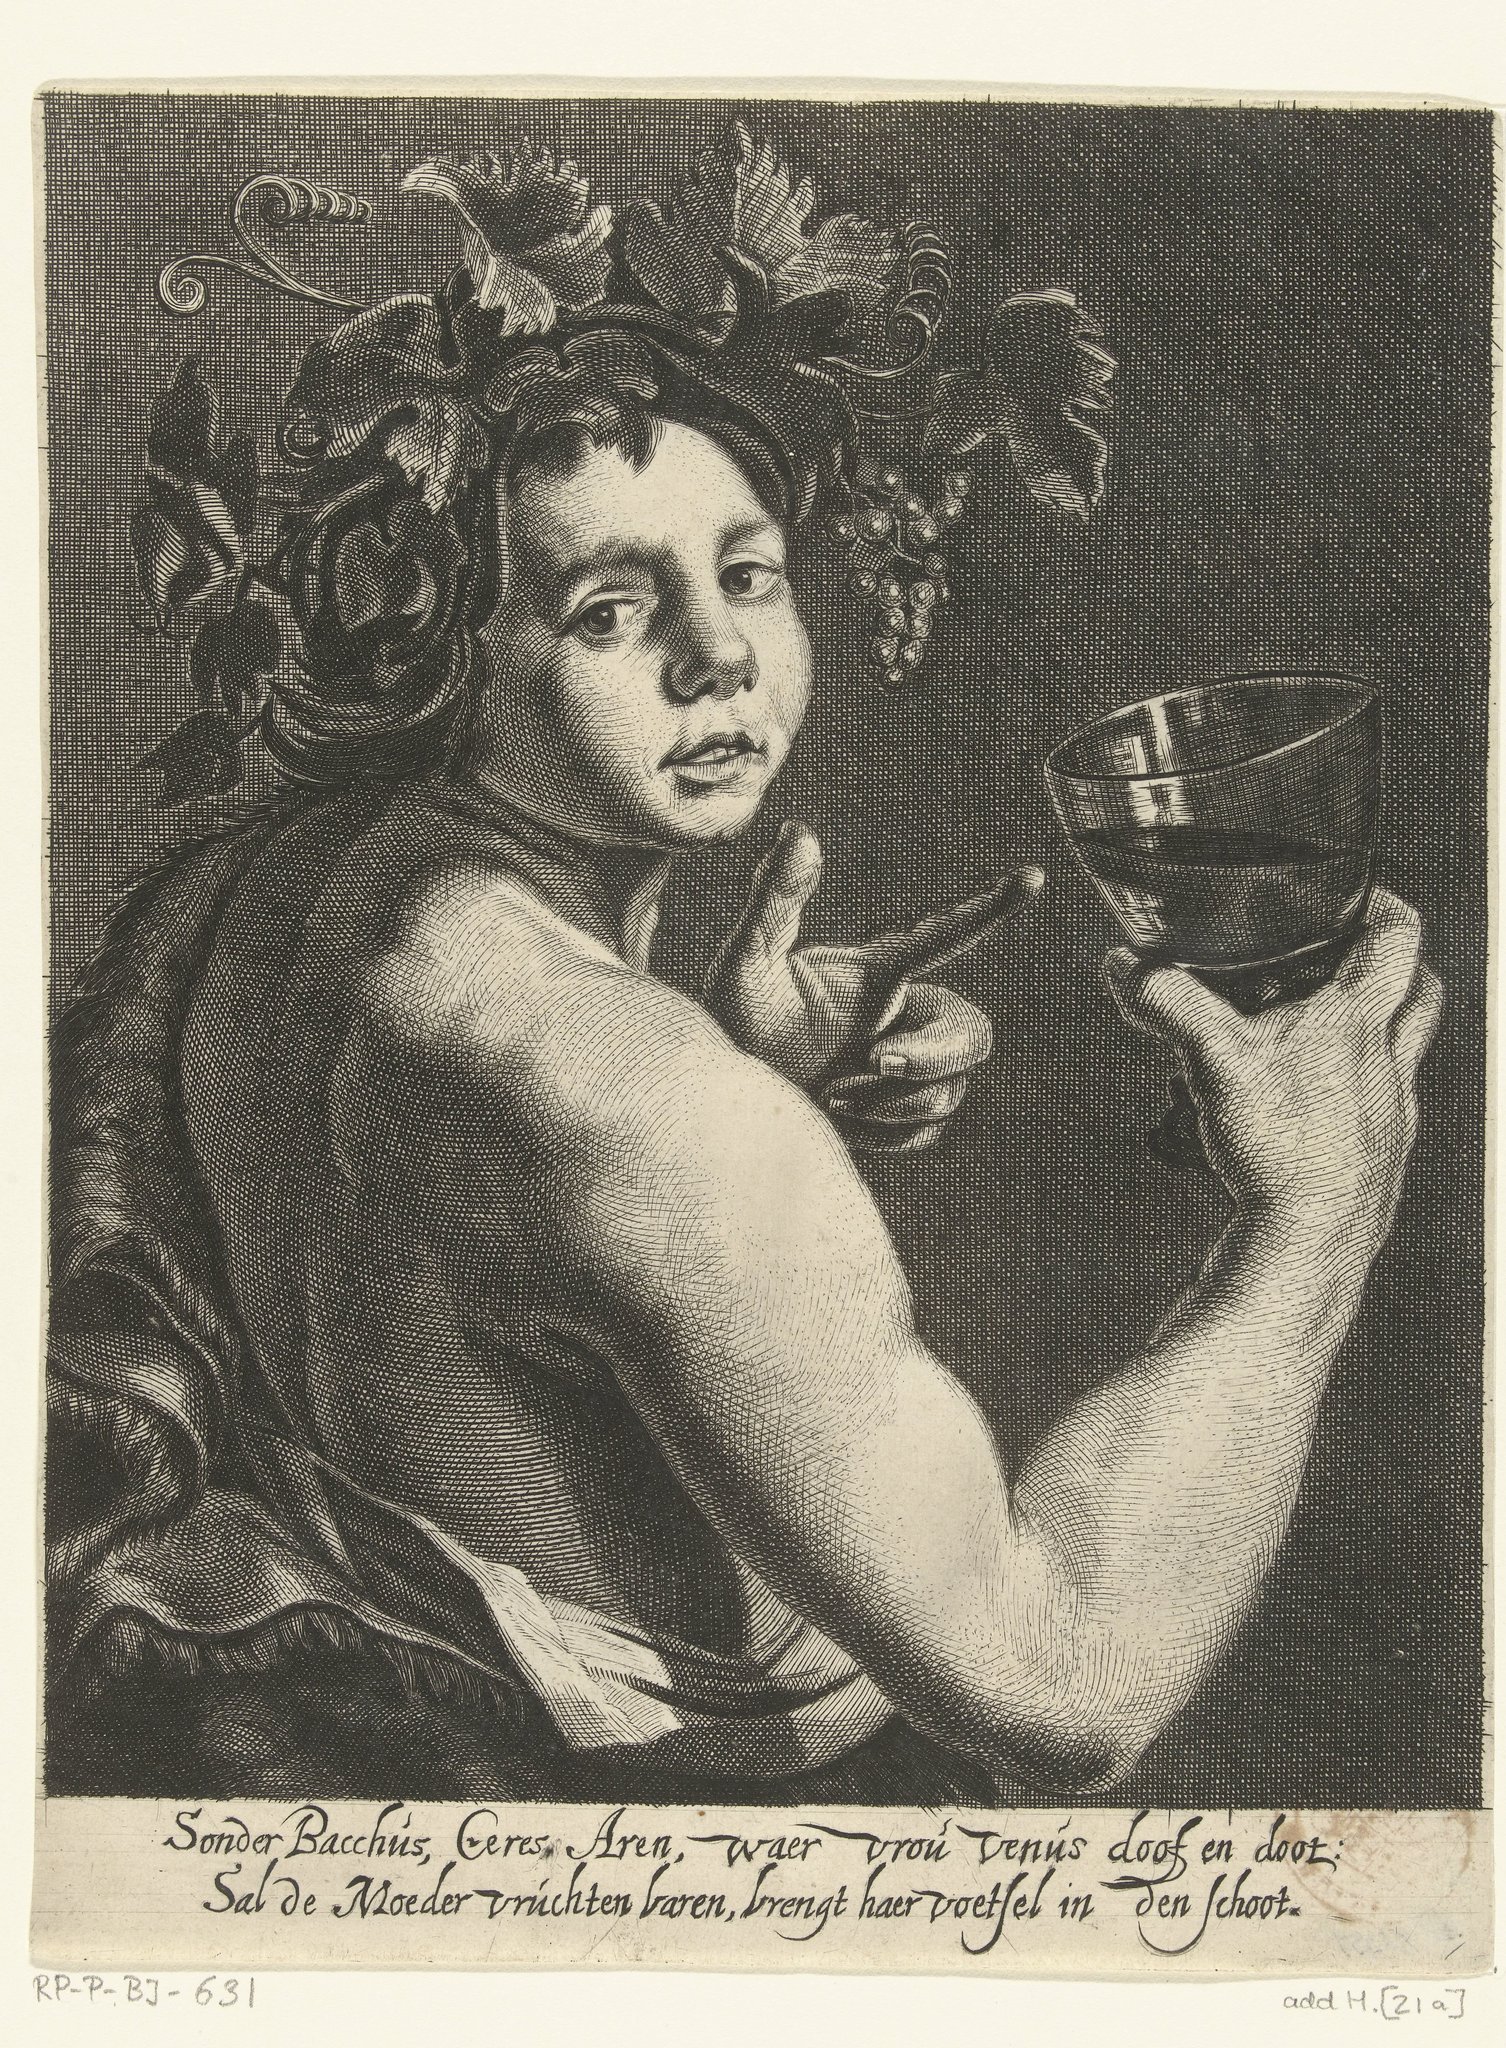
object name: print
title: Jonge Bacchus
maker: hendrik bary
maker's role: draughtsman, print maker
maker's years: 1640-1707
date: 1657-1707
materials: paper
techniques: engraving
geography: netherlands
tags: (story of) bacchus (dionysus), liber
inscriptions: collector's mark: Lugt 240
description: Een jonge Bacchus met een halfgevuld glas in zijn hand. Onder de voorstelling een vers van twee regels in het Nederlands.